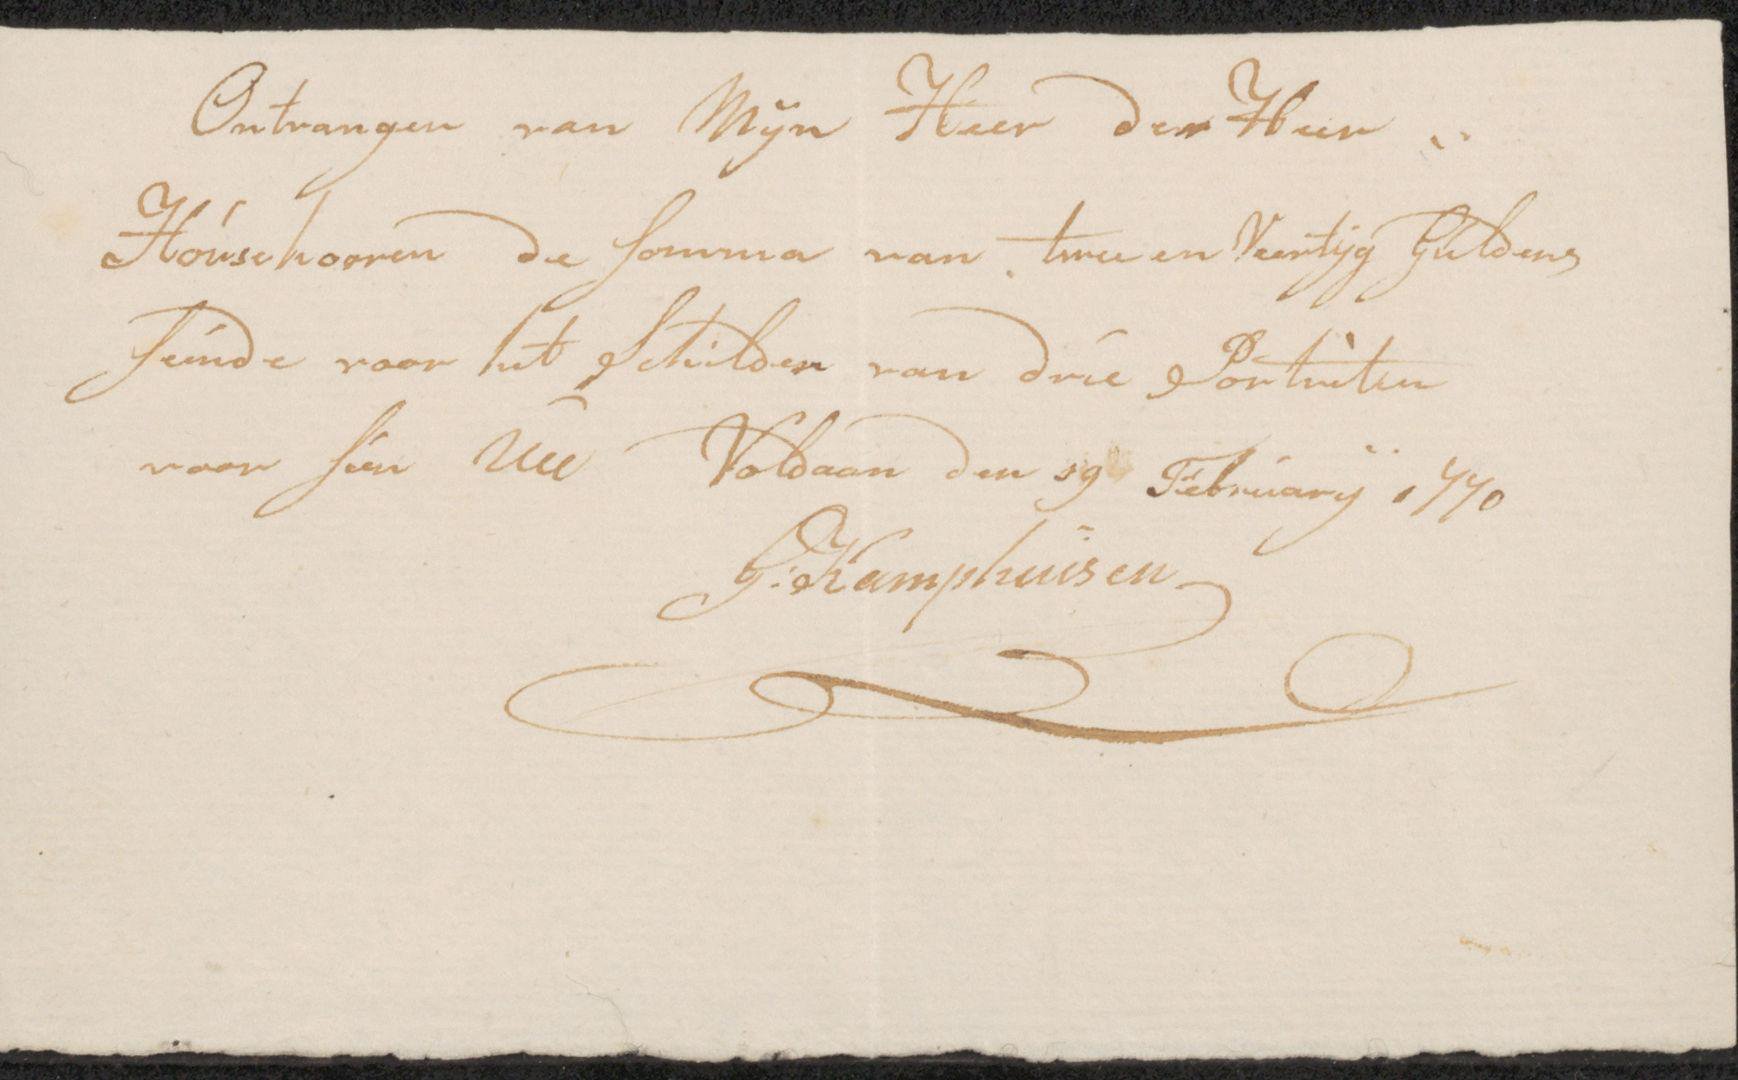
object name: ontvangstbewijs, kwitantie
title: Kwitantie voor de heer Househoven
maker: gerrit kamphuysen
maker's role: miniatuurschilder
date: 1770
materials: ink, paper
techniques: pen, writing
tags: anonymous historical person portrayed, painting (including book-illumination, miniature-painting), money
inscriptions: collector's mark: Lugt 2233